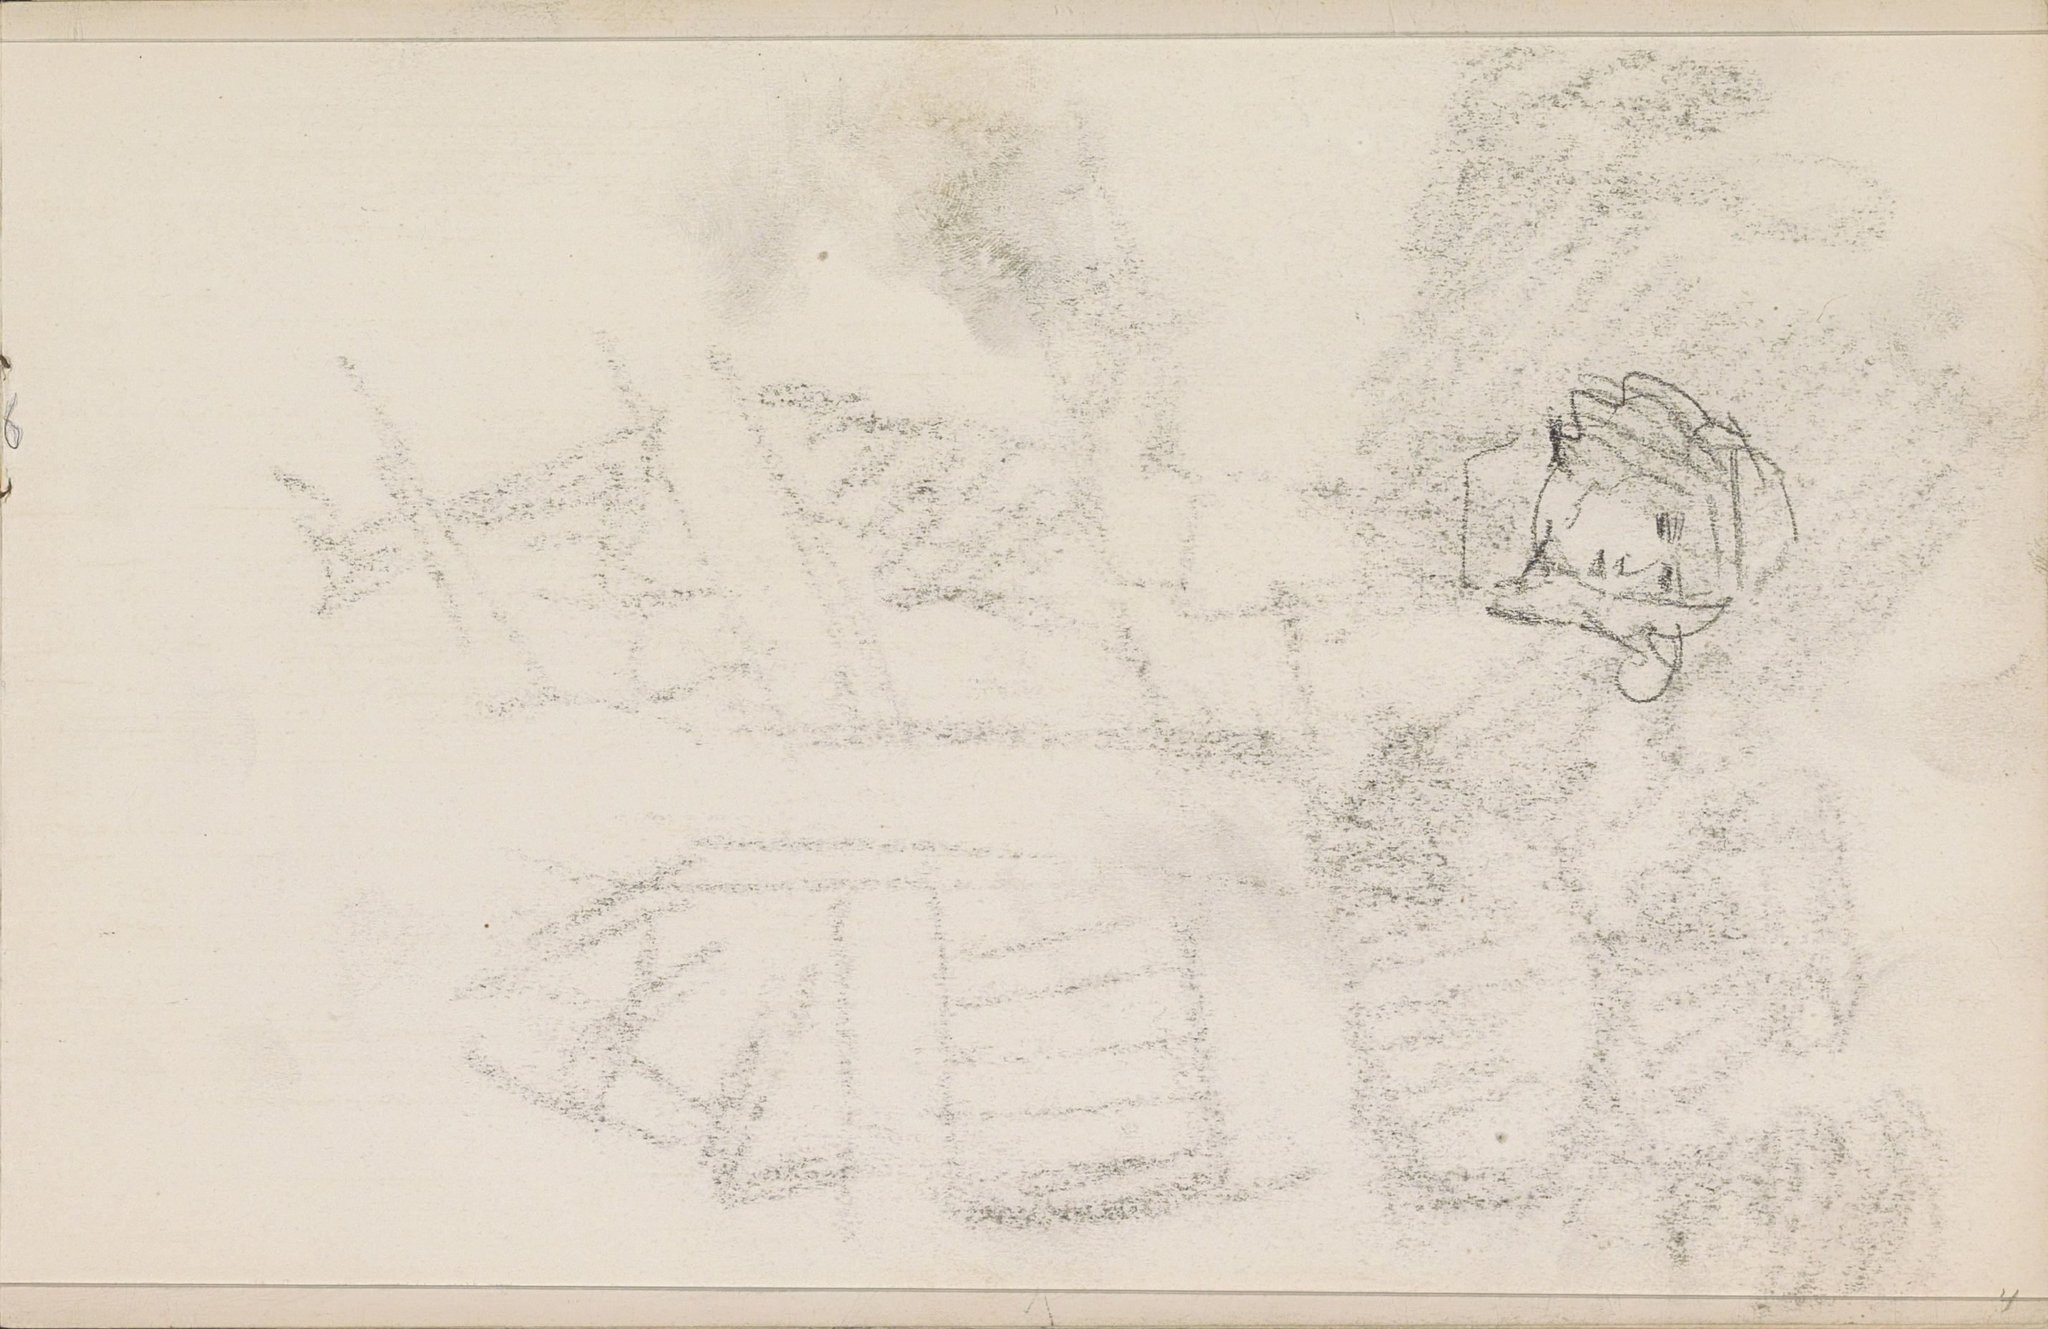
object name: sketchbook leaf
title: Vrouwenhoofd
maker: isaac israels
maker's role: draughtsman, painter, print maker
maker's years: 1865-1934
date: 1875-1934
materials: chalk, paper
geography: paris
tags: head (human) - aa - female human figure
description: Blad 4 recto uit schetsboek LI met 11 bladen.